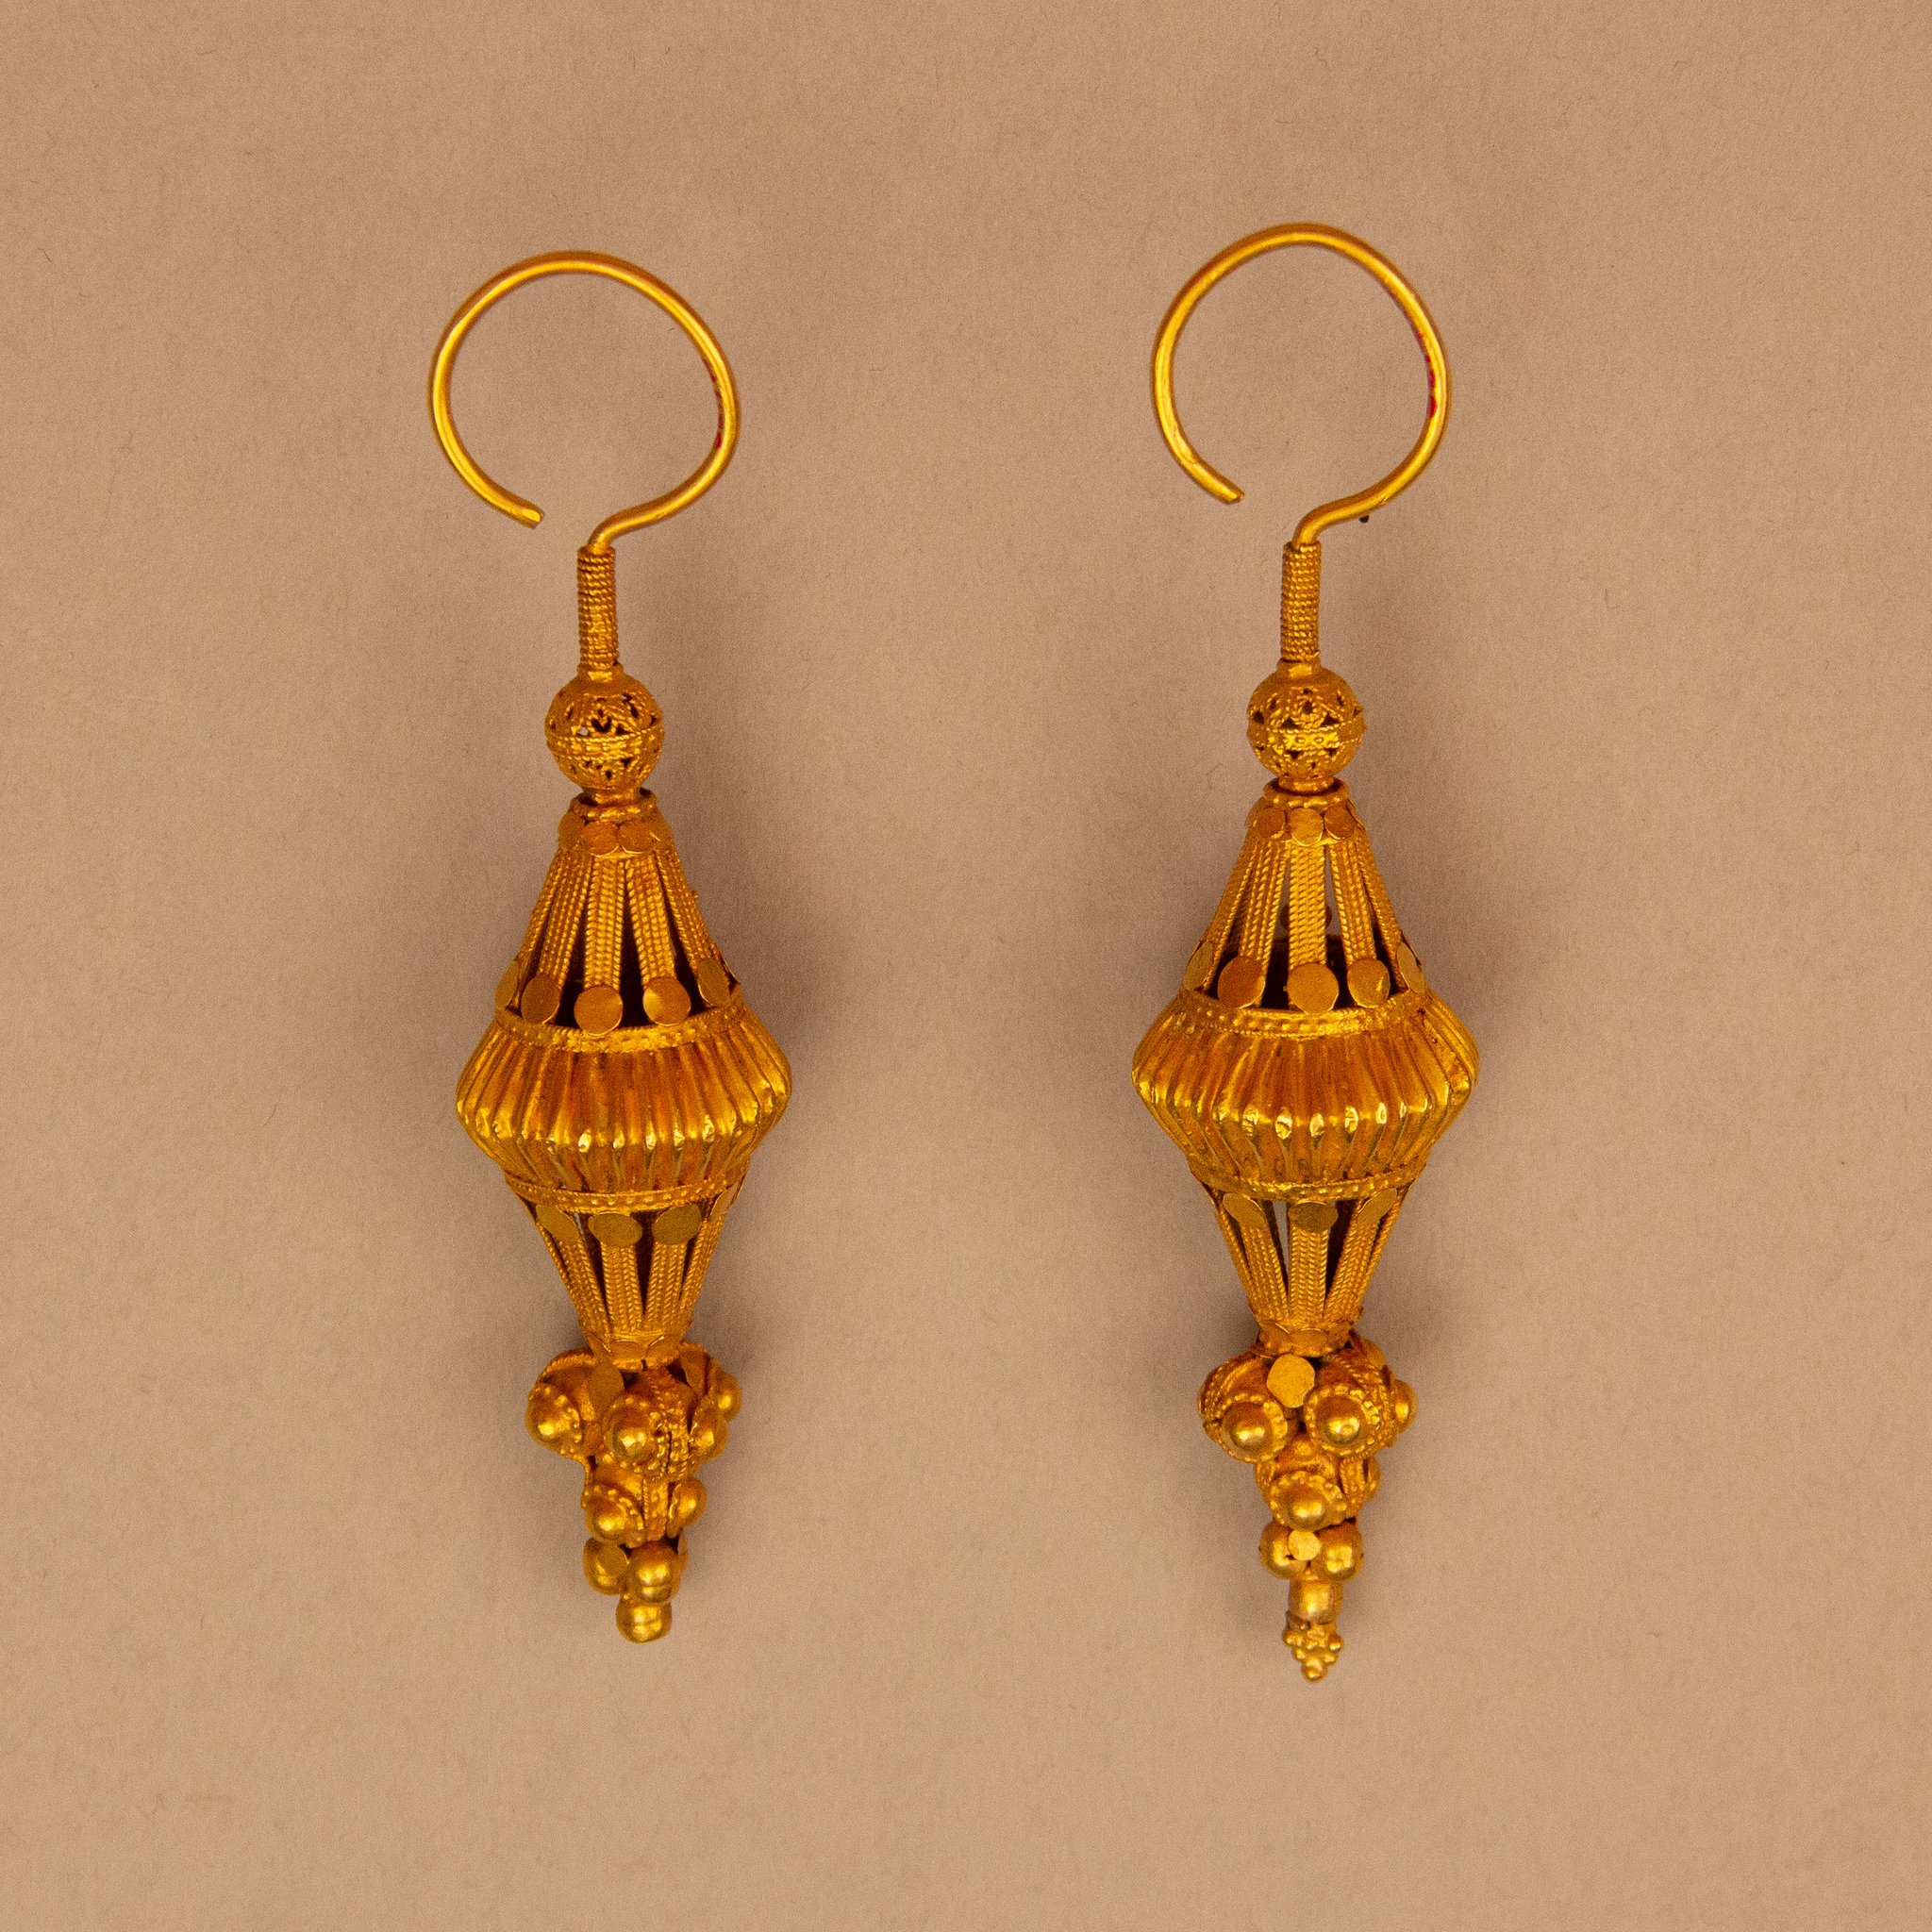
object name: earring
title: Earring, One of a Pair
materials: gold, metal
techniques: filigree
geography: saudi arabia